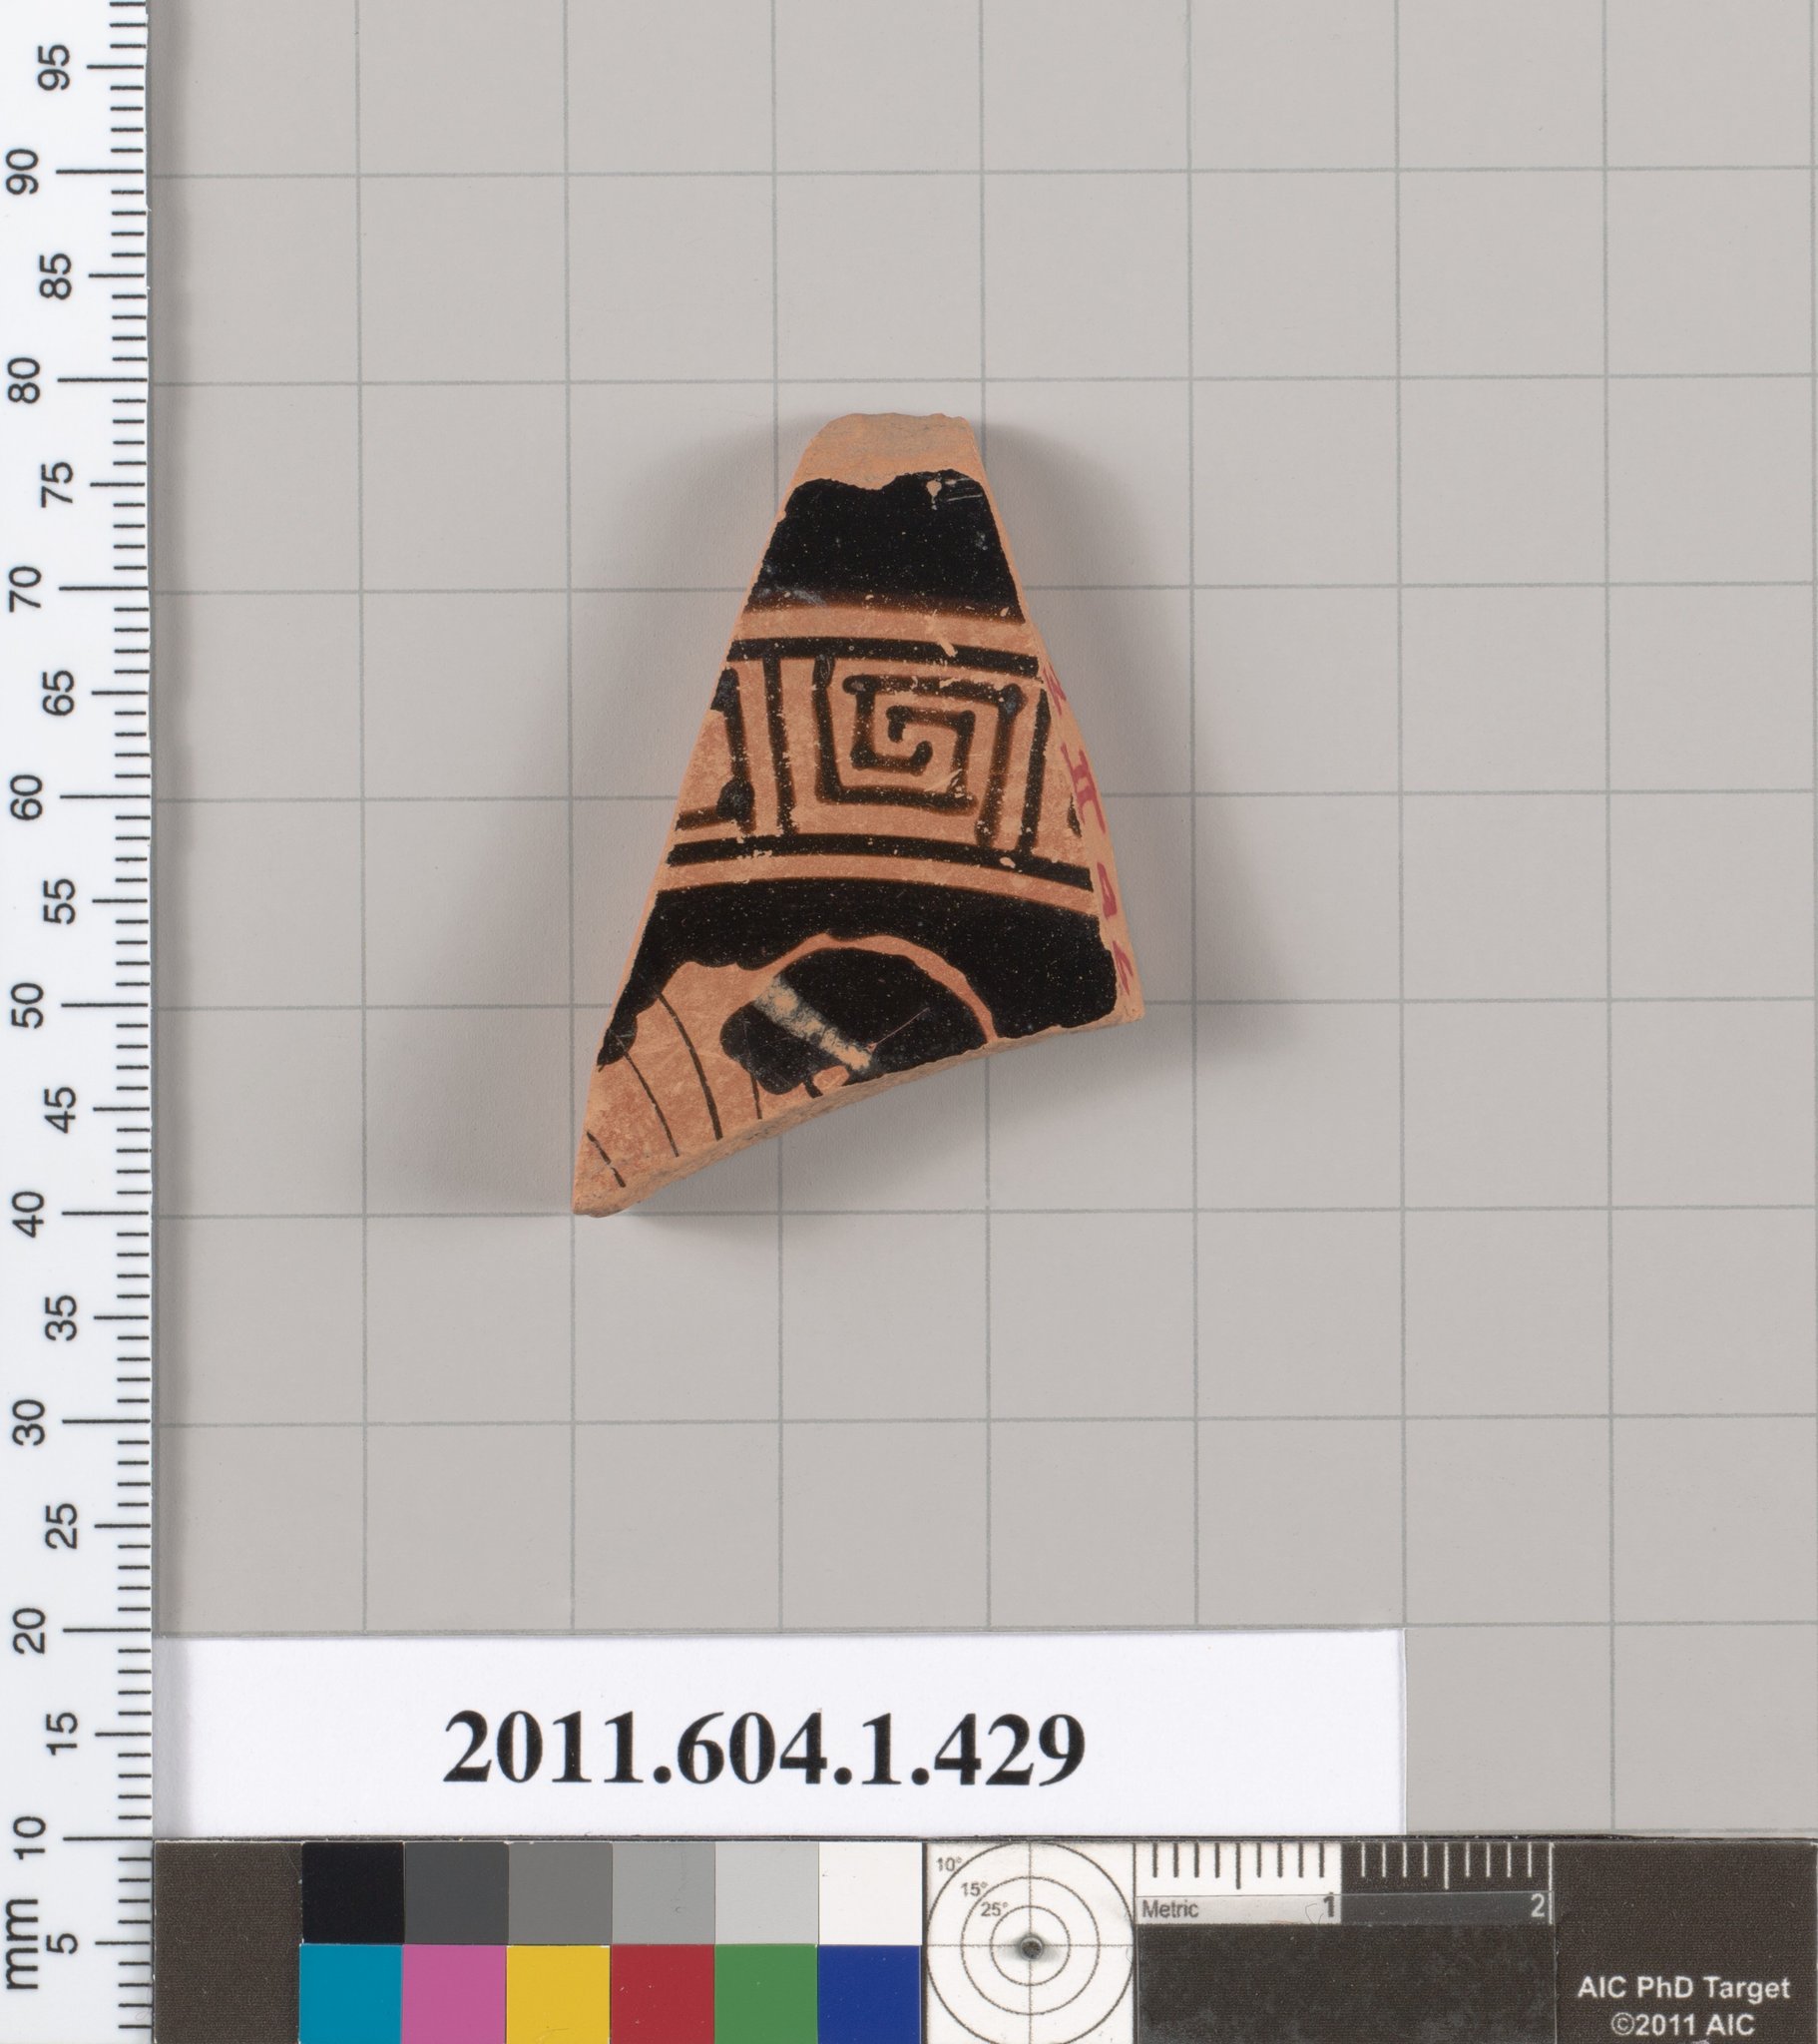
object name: kylix fragment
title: Terracotta fragment of a kylix (drinking cup)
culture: greek, attic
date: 475-451 BCE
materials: terracotta